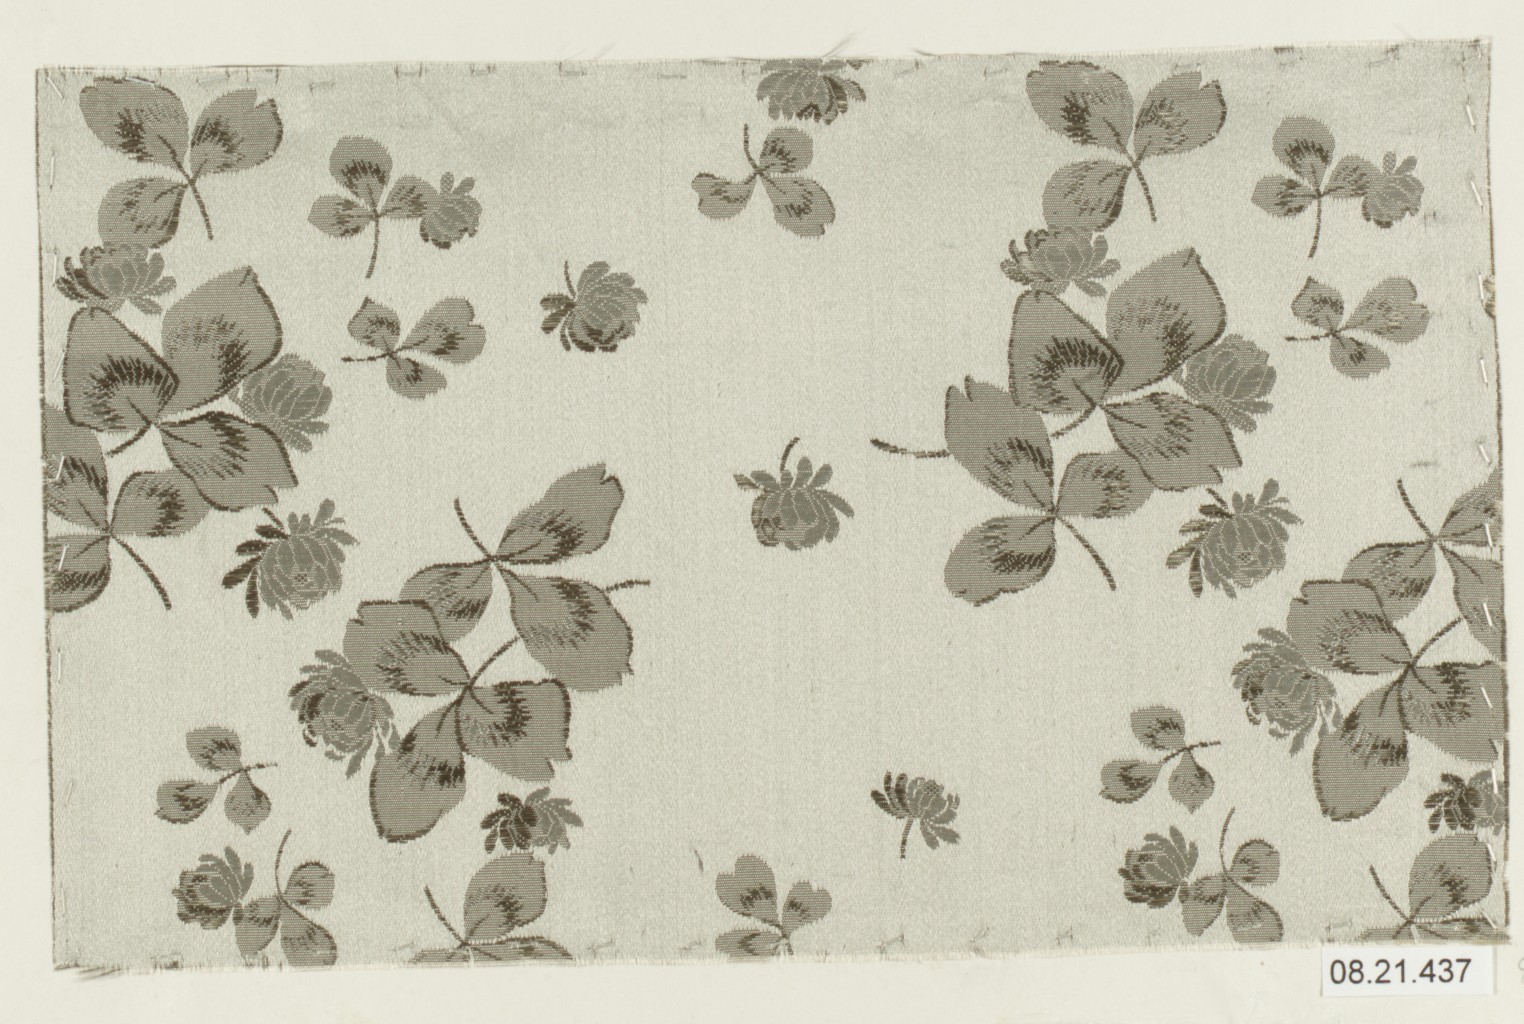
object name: textile sample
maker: Anonymous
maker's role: designer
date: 1900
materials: silk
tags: leaves